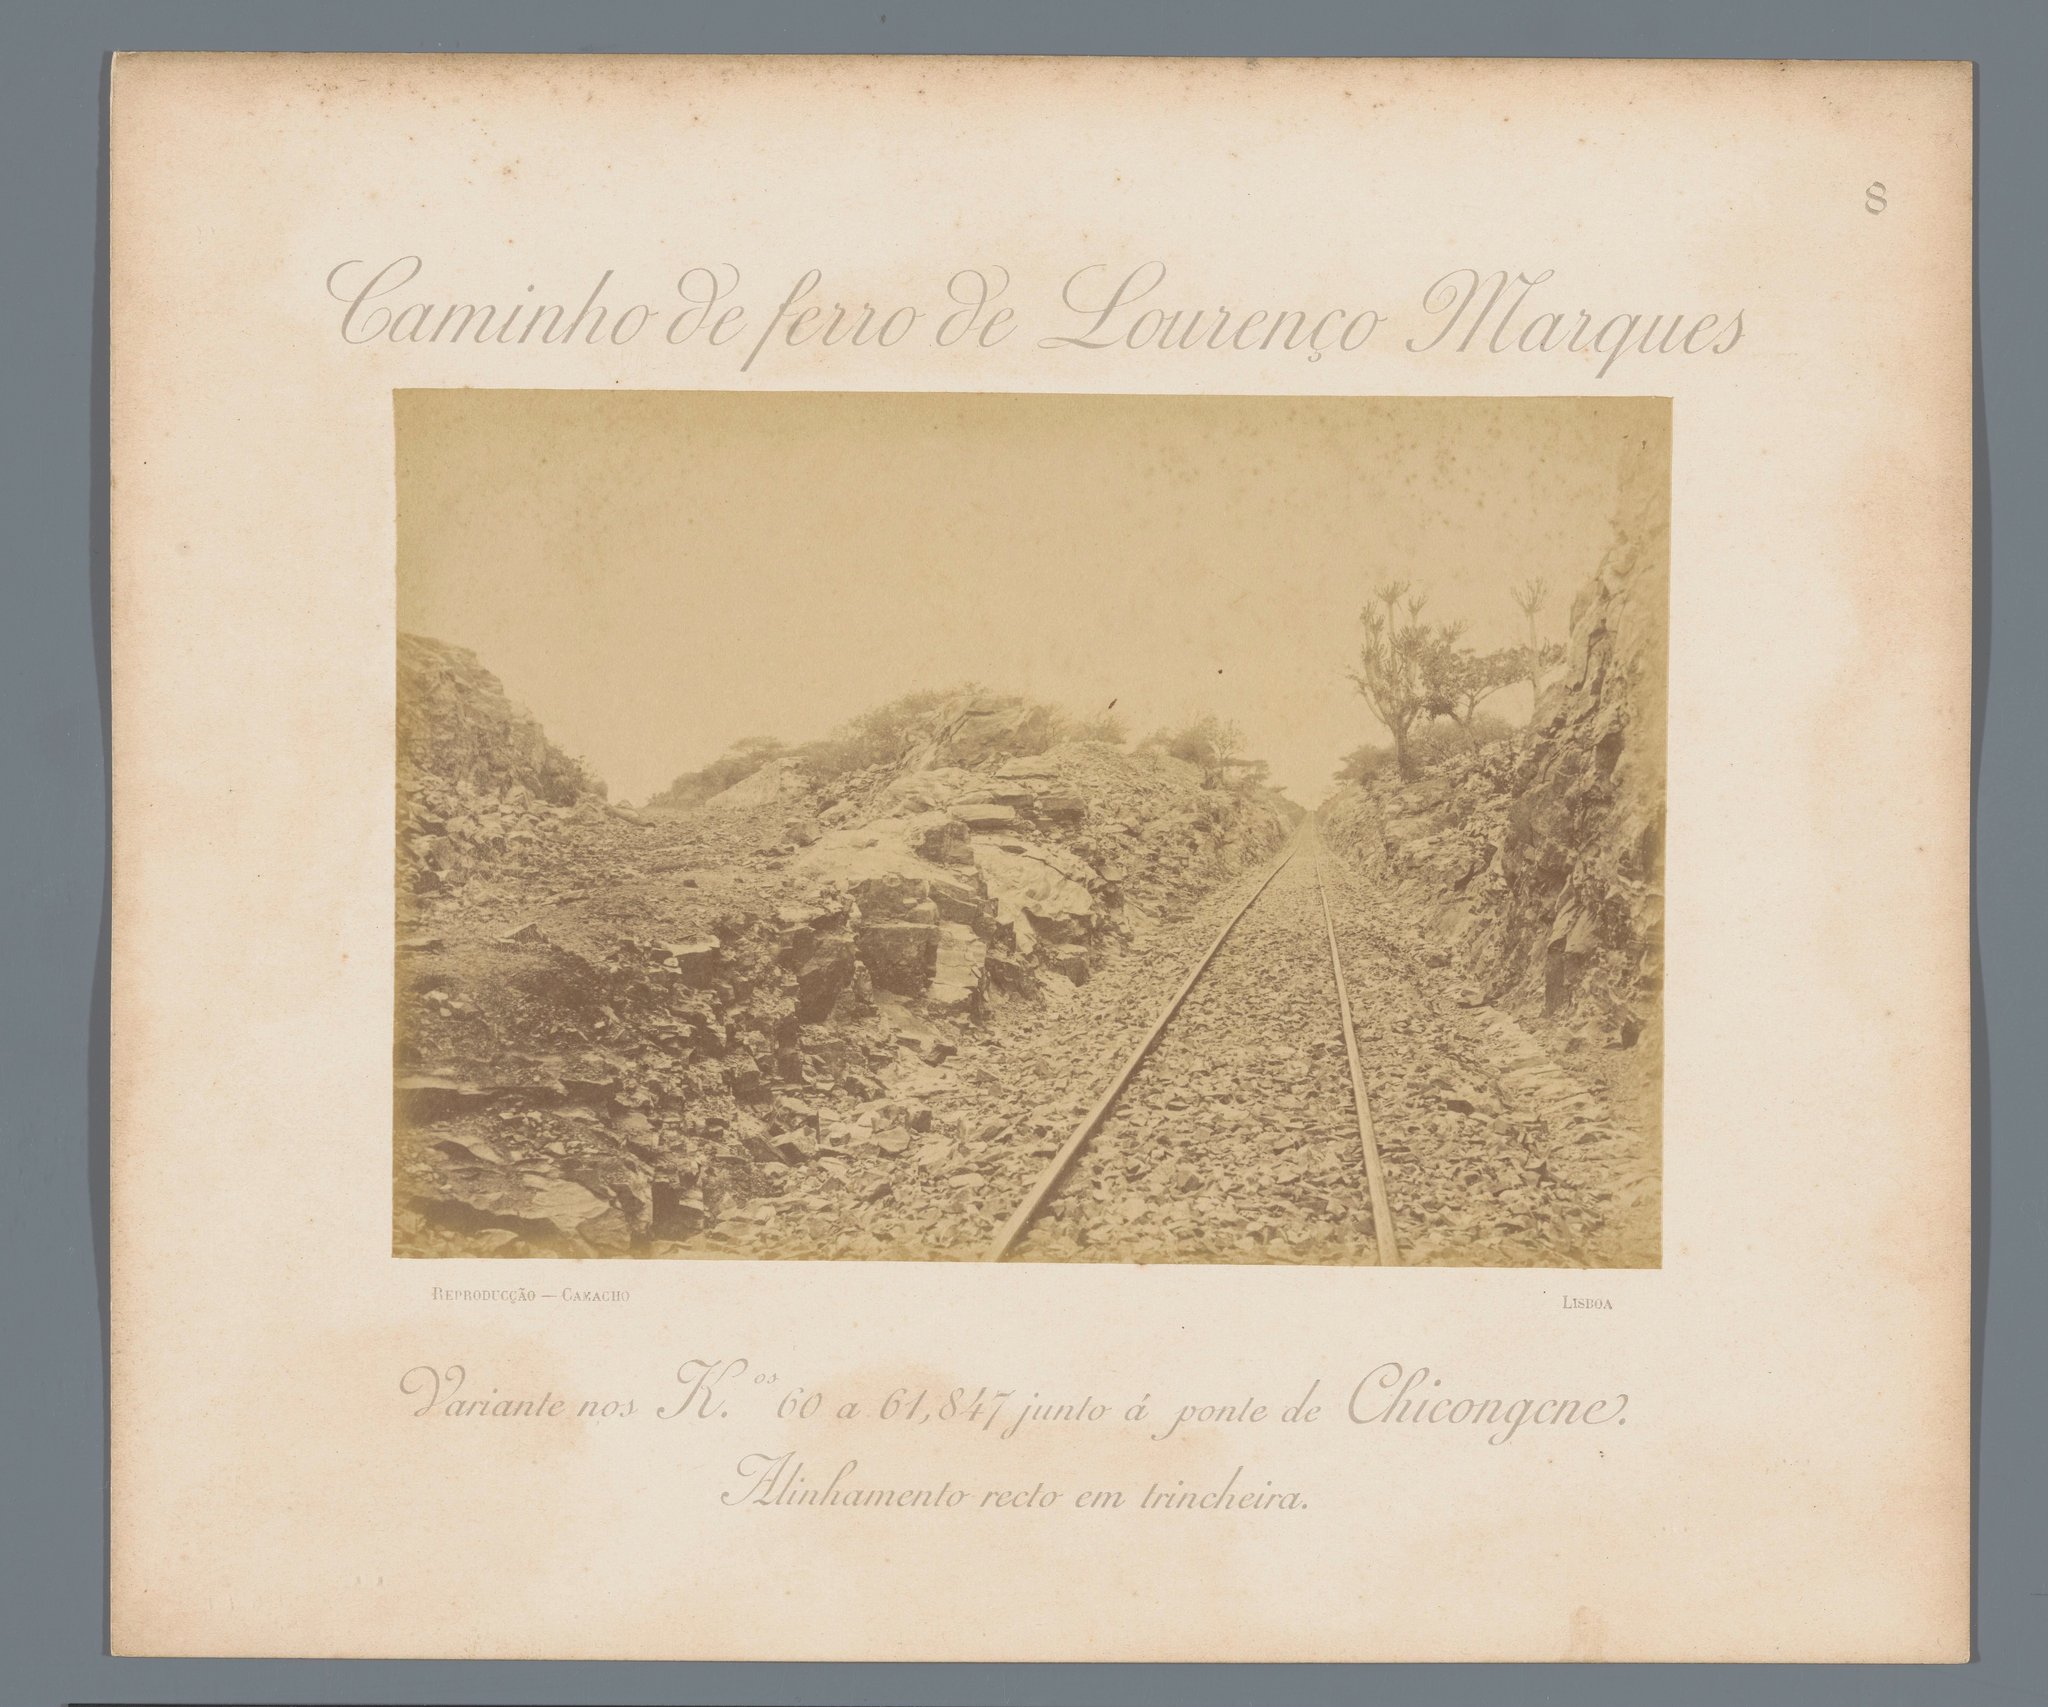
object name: page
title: Variante nos K.ºs 60 a 61, 847 junto á ponte Chicongene. Alinhamento recto em trincheira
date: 1886-1895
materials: photographic support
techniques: albumen print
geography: mozambique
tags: railway, train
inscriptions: number: ‘8’